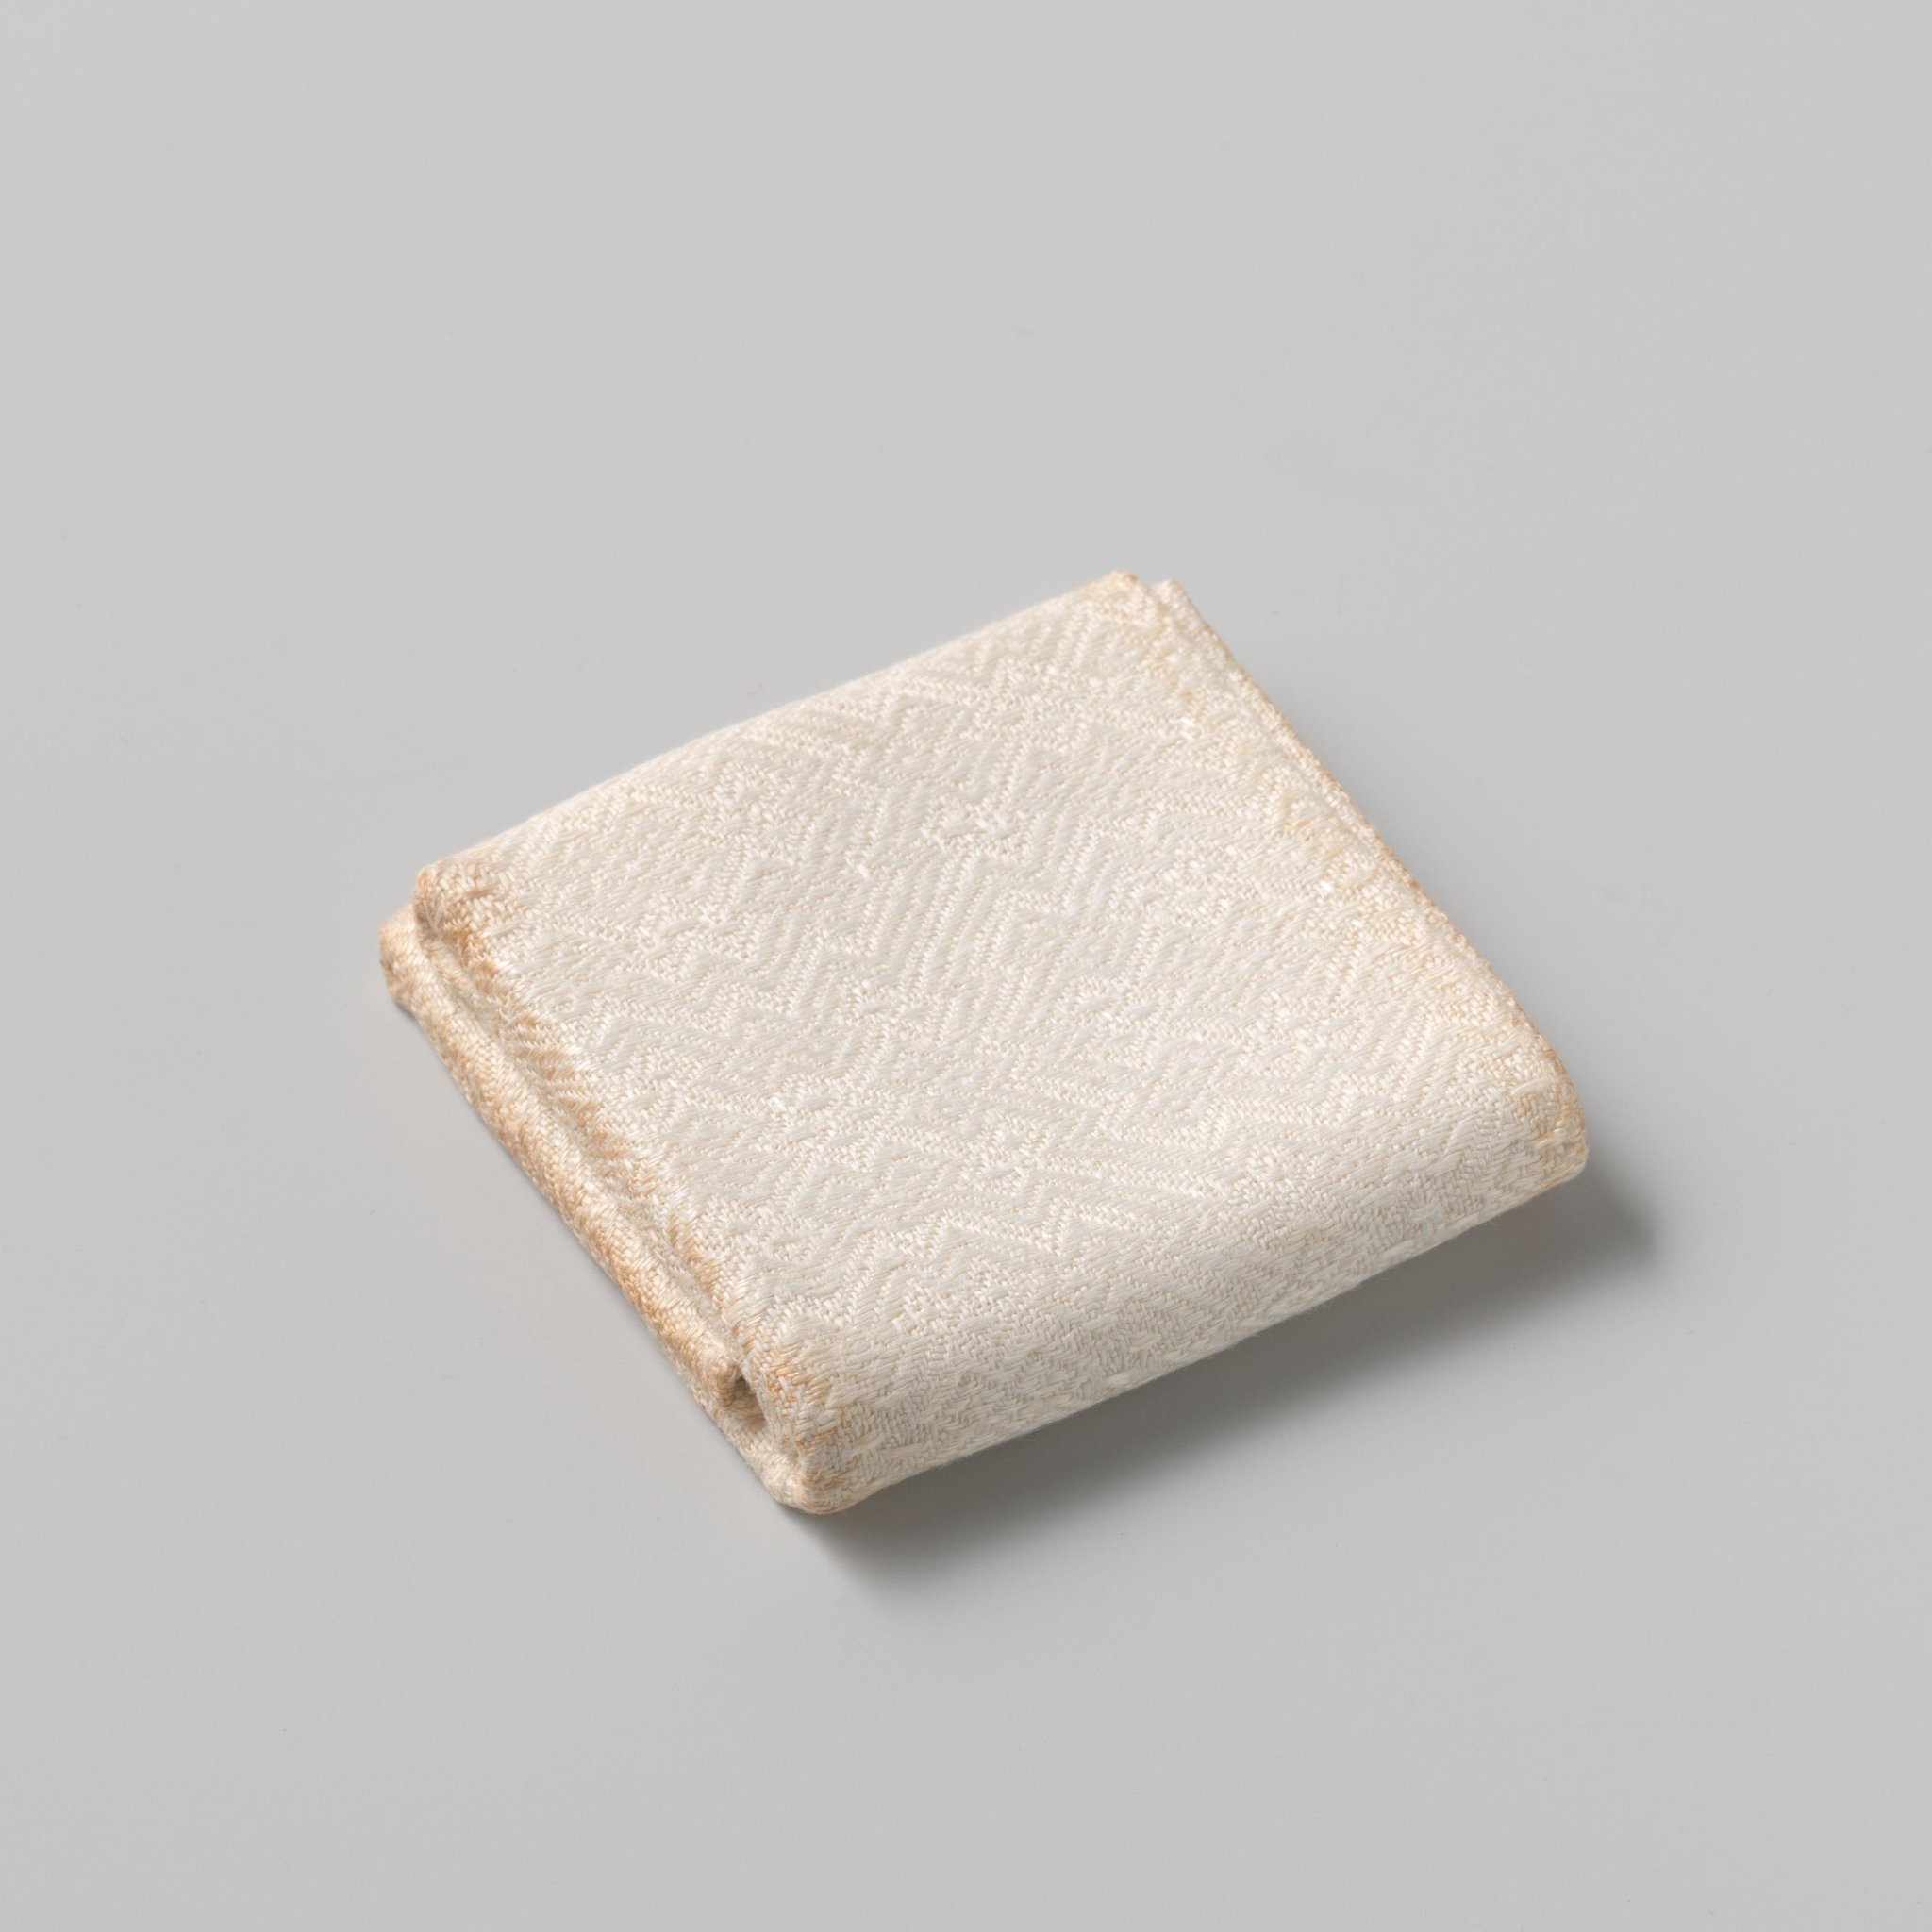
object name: tablecloth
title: Tafellaken, damastweefsel met een pellenpatroon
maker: Anonymous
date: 1600-1699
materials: linen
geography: netherlands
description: Tafellaken, damastweefsel met een pellenpatroon, geknipt uit grotere stukken linnen en aan alle kanten omgezoomd met een fijne zoom.